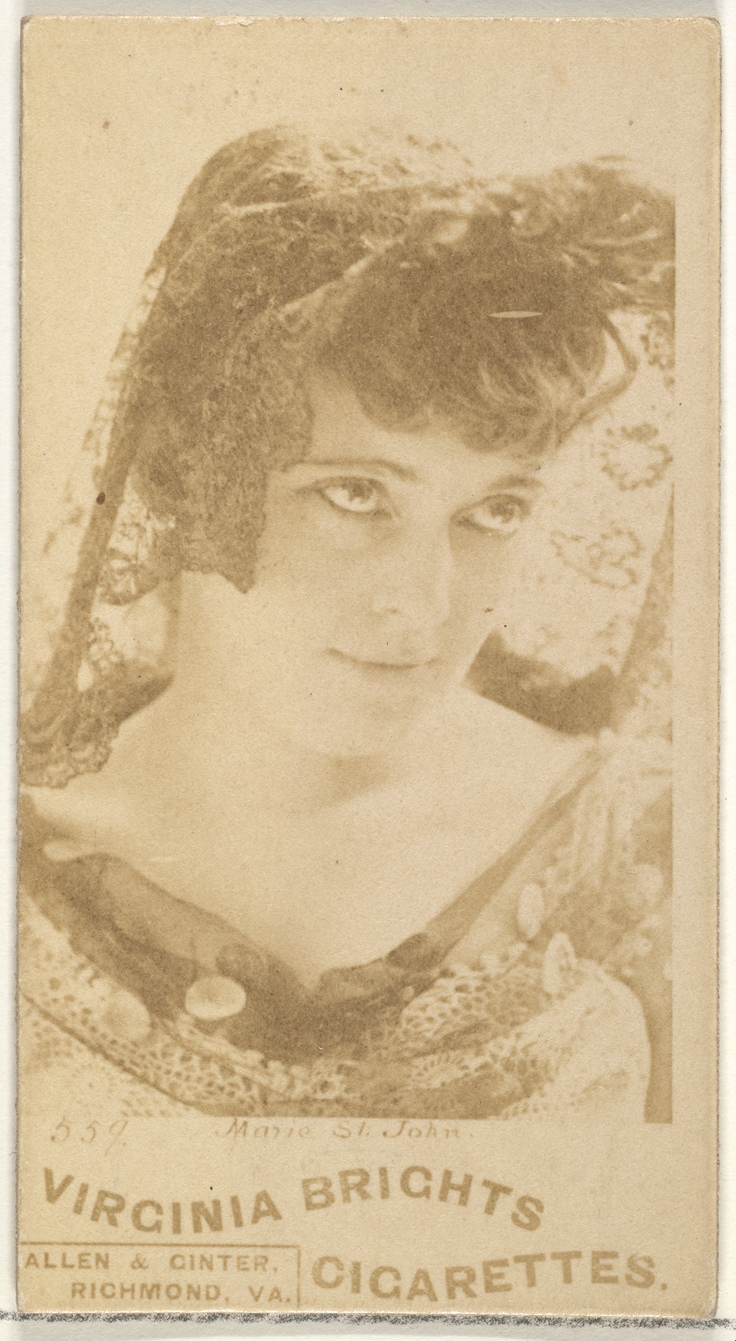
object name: photograph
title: Card 559, Marie St. John, from the Actors and Actresses series (N45, Type 1) for Virginia Brights Cigarettes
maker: allen & ginter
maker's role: publisher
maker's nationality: american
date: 1888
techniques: albumen silver print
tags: portraits,women,actresses